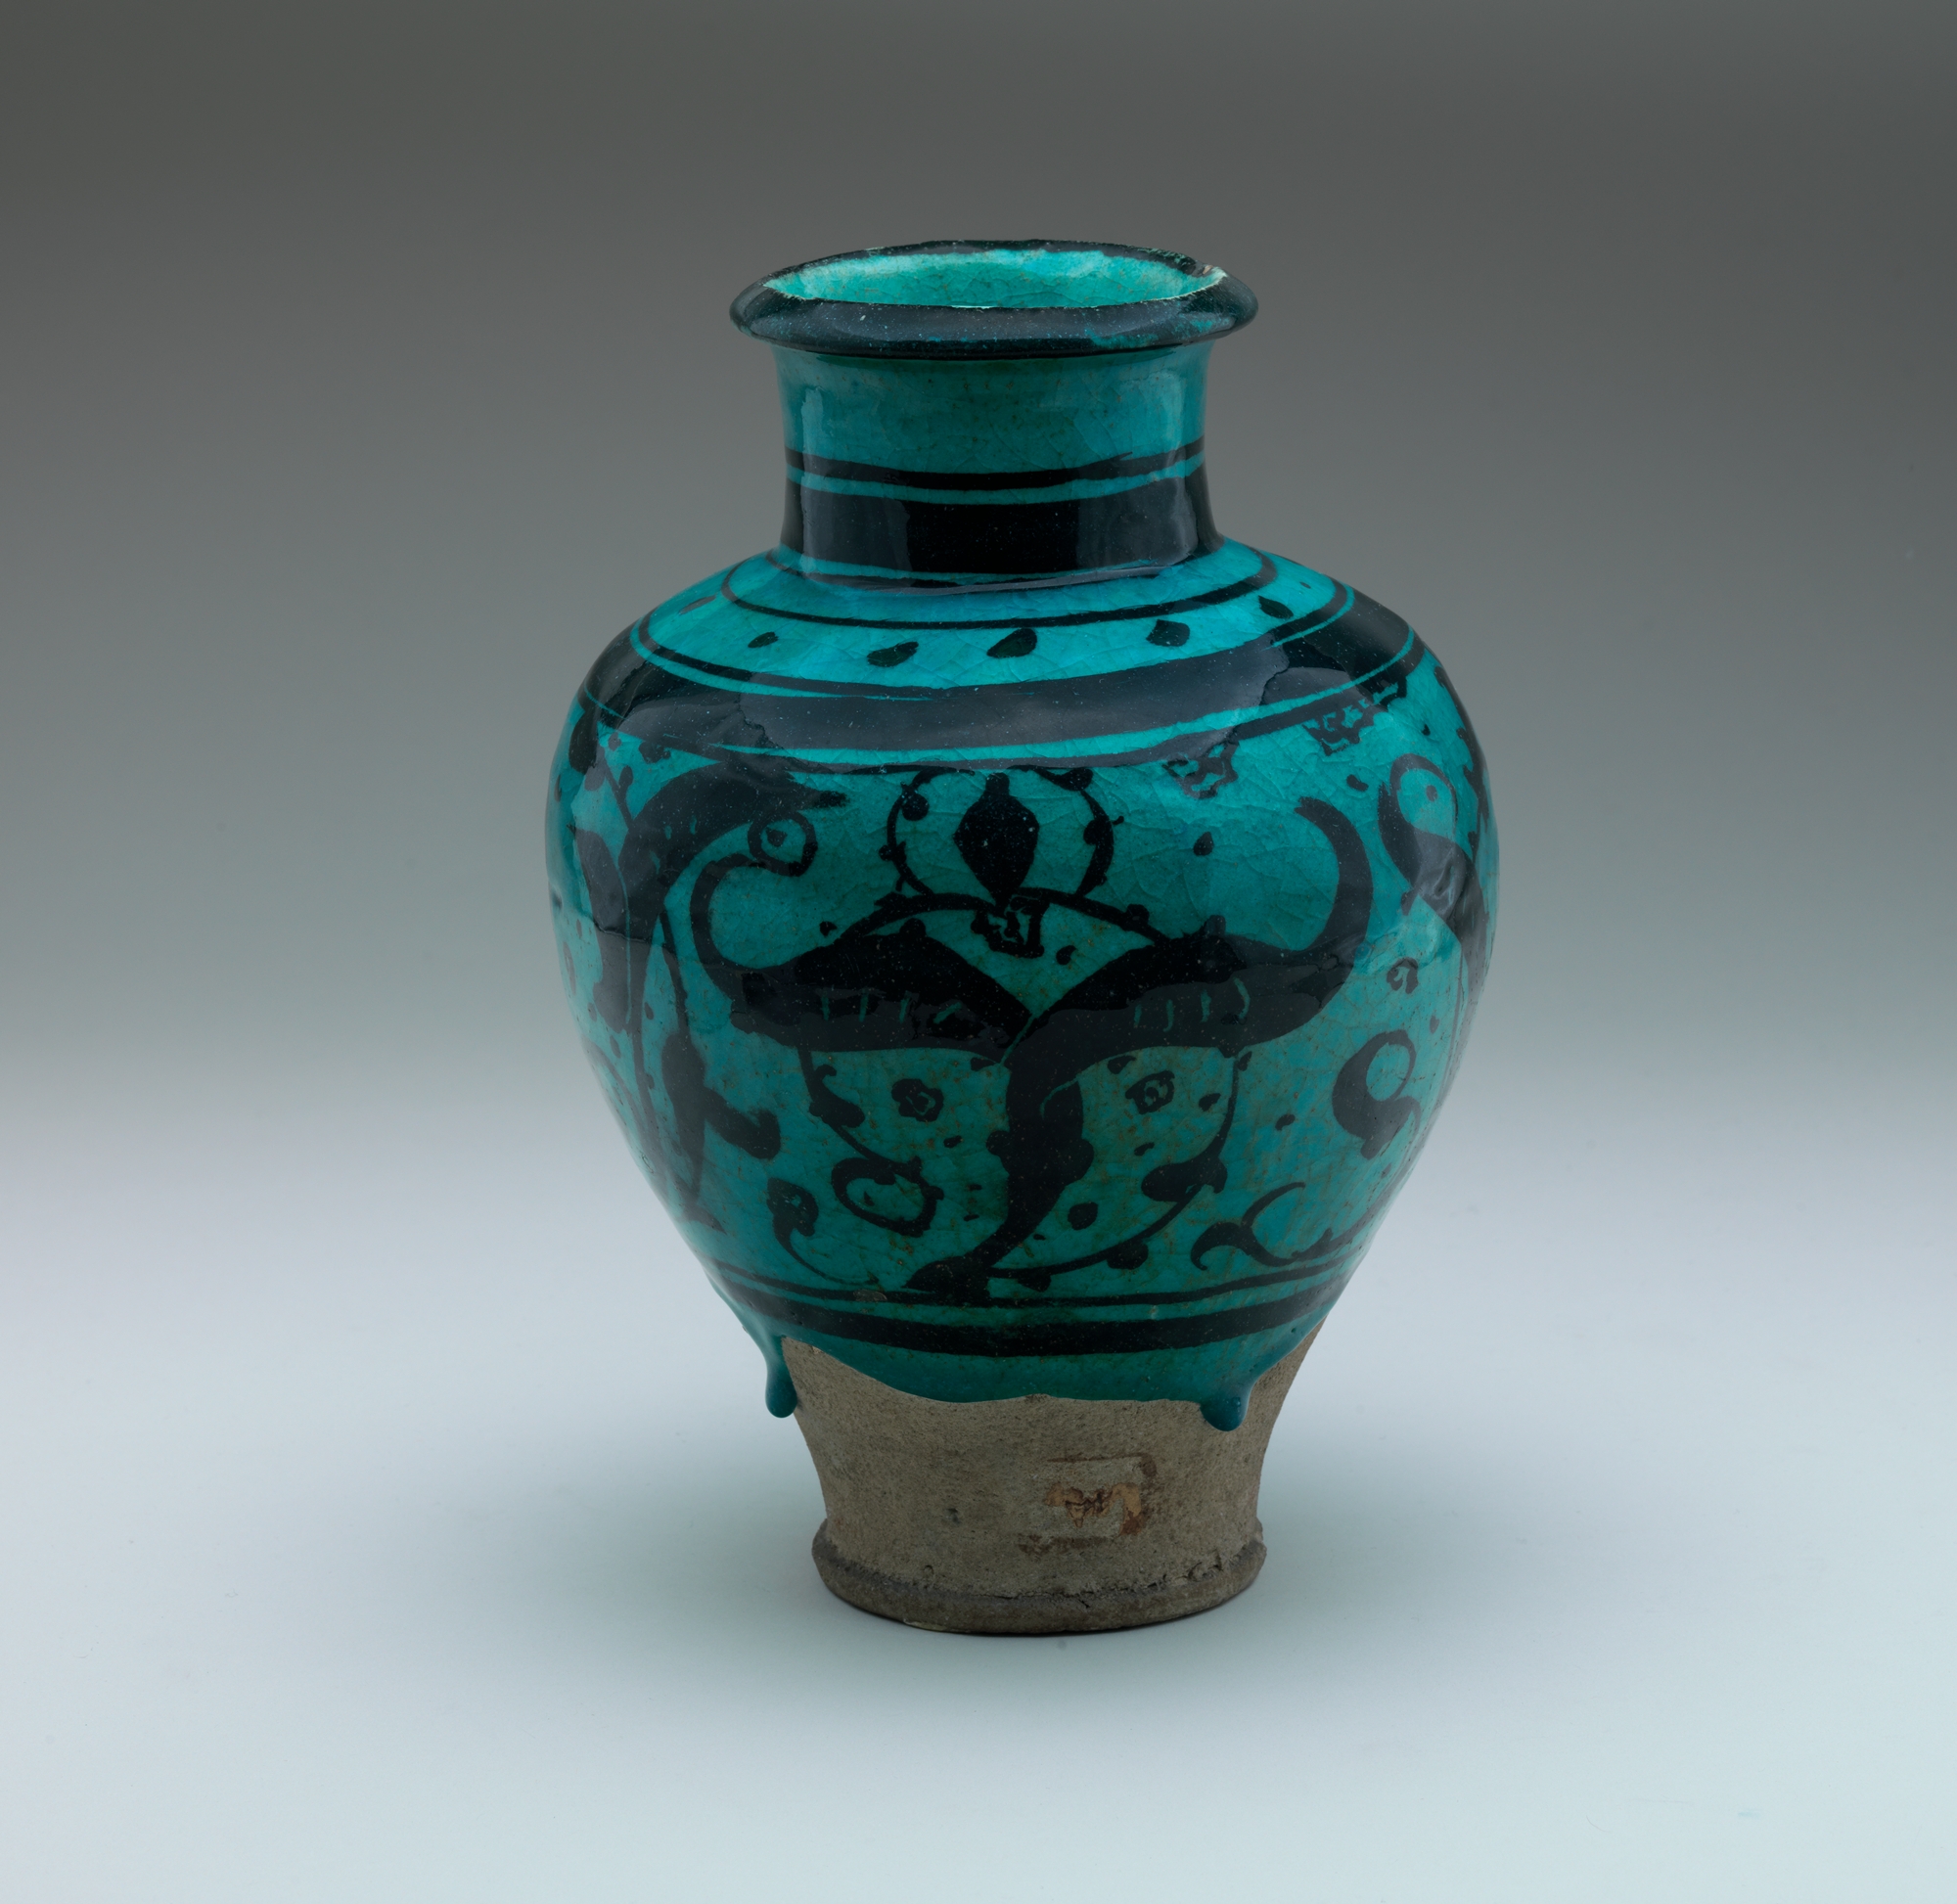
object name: jar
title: Pear-Shaped Jar with Stylized Vegetal Decoration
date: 1201-1250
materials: glaze, stonepaste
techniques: painting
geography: syria